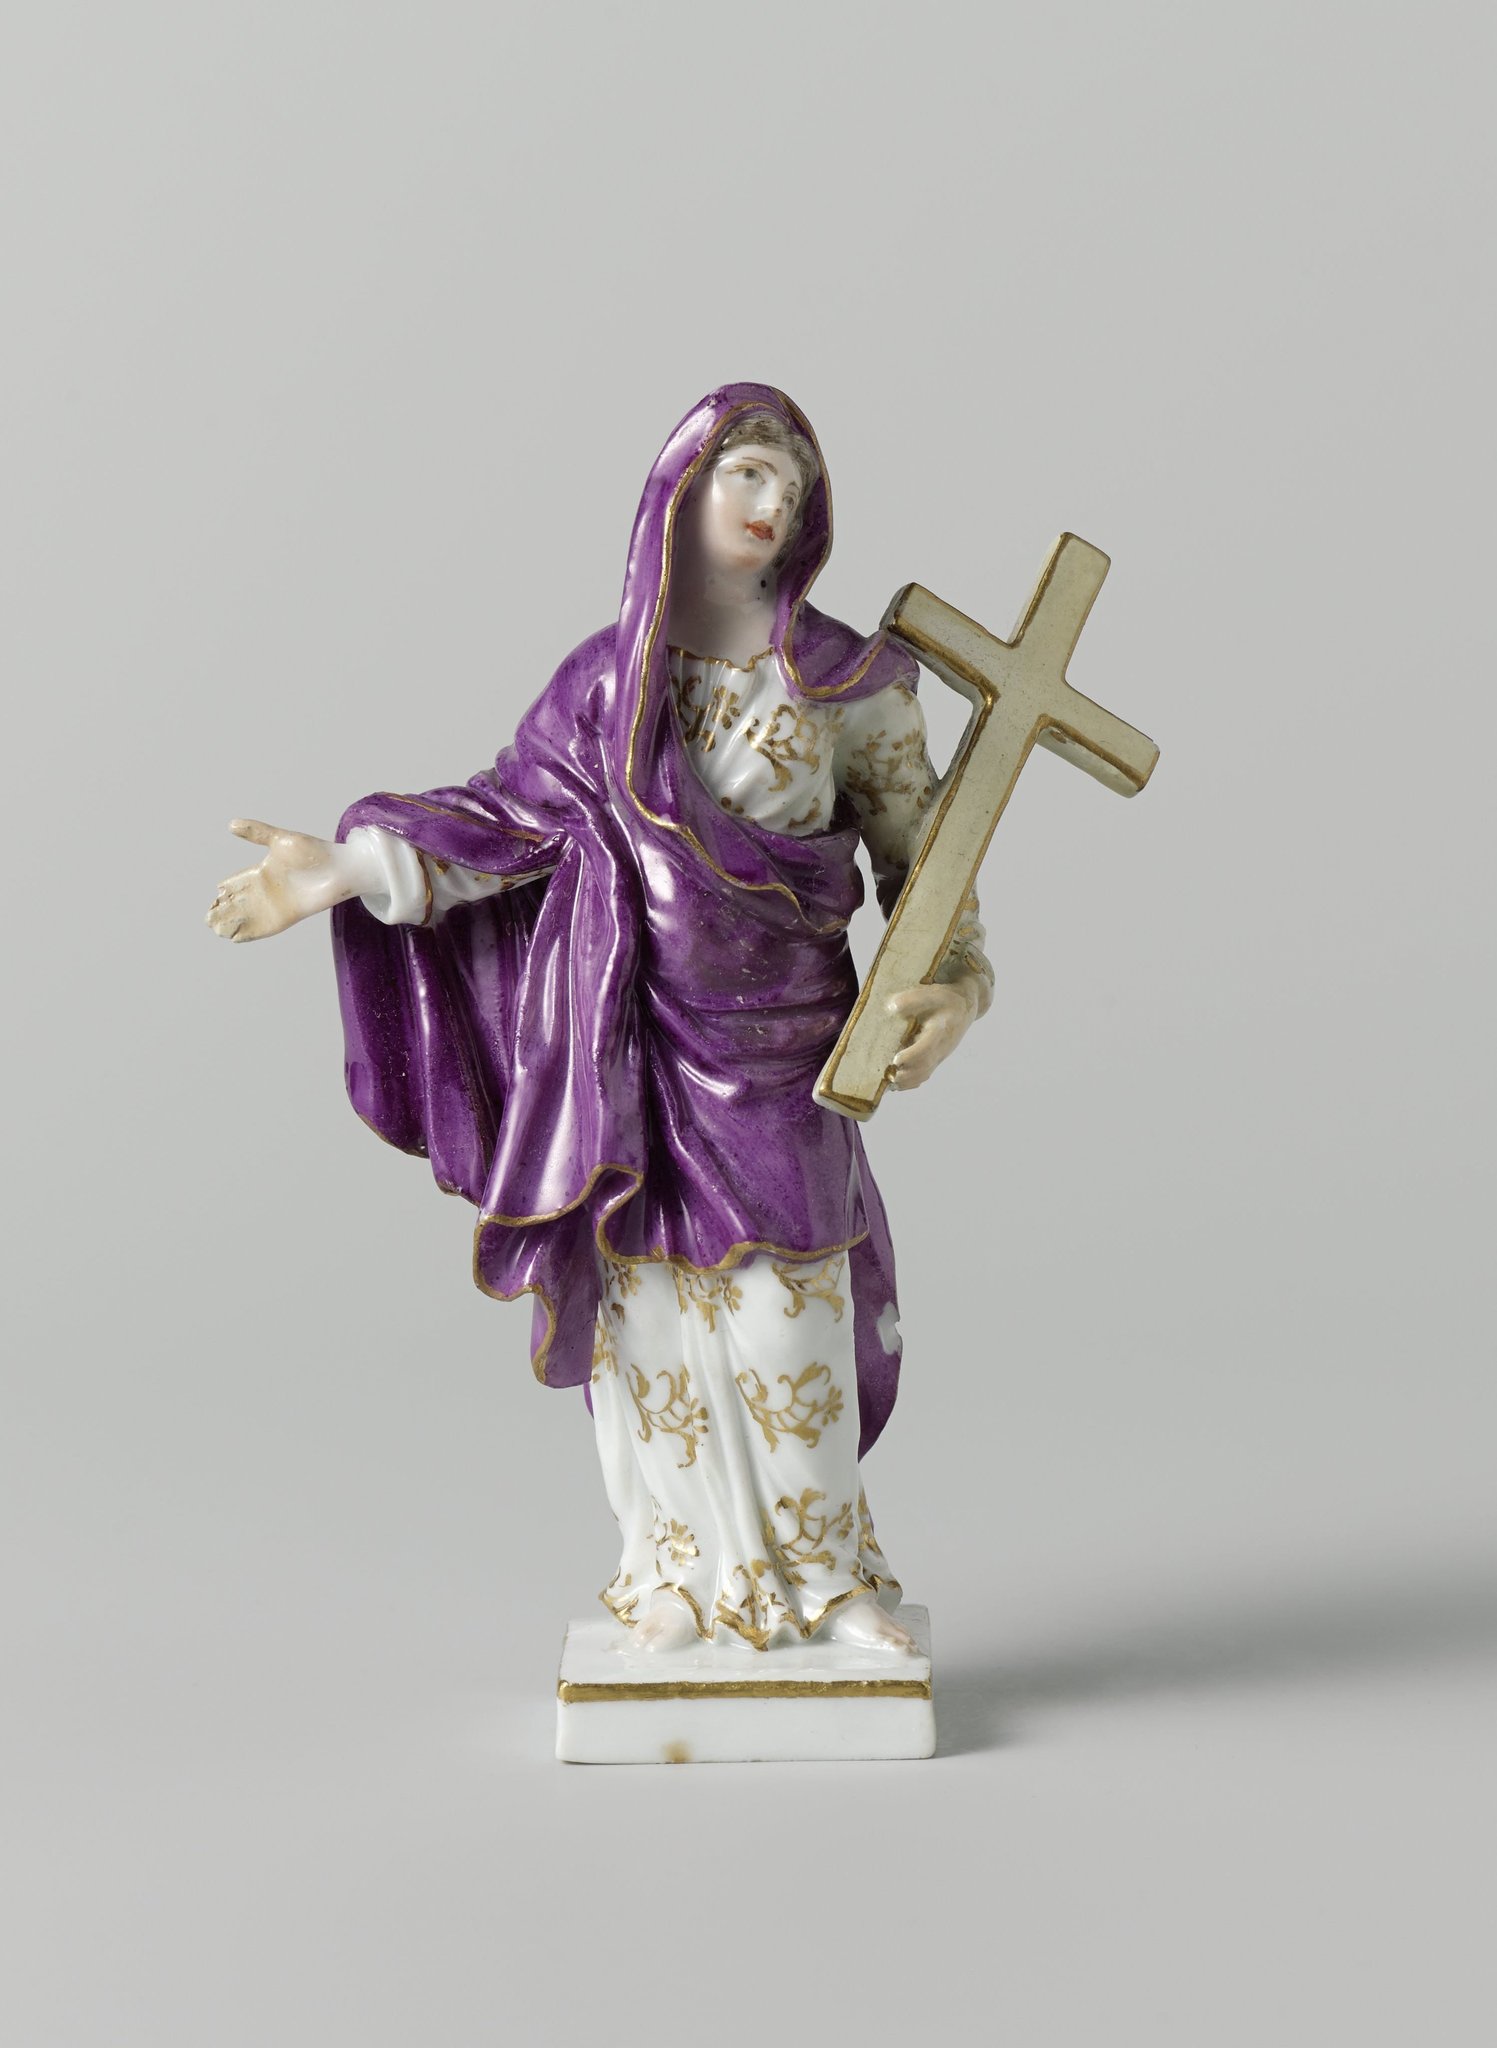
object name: figure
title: Fides (Geloof)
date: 1779-1800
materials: porcelain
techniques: painted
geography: meissen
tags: faith, 'fides'; 'fede', 'fede catholica', 'fede christiana', 'fede christiana catholica' (ripa) ~ one of the three theological virtues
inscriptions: factory mark, model number: ‘617’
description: Figuur van beschilderd porselein. Op een vierkant goud gerand voetstuk staat een vrouw (Fides) met een kruis in haar linkerhand. Zij draagt een wit kleed beschilderd met gouden bloemen en een paarse mantel. De figuur is gemerkt.